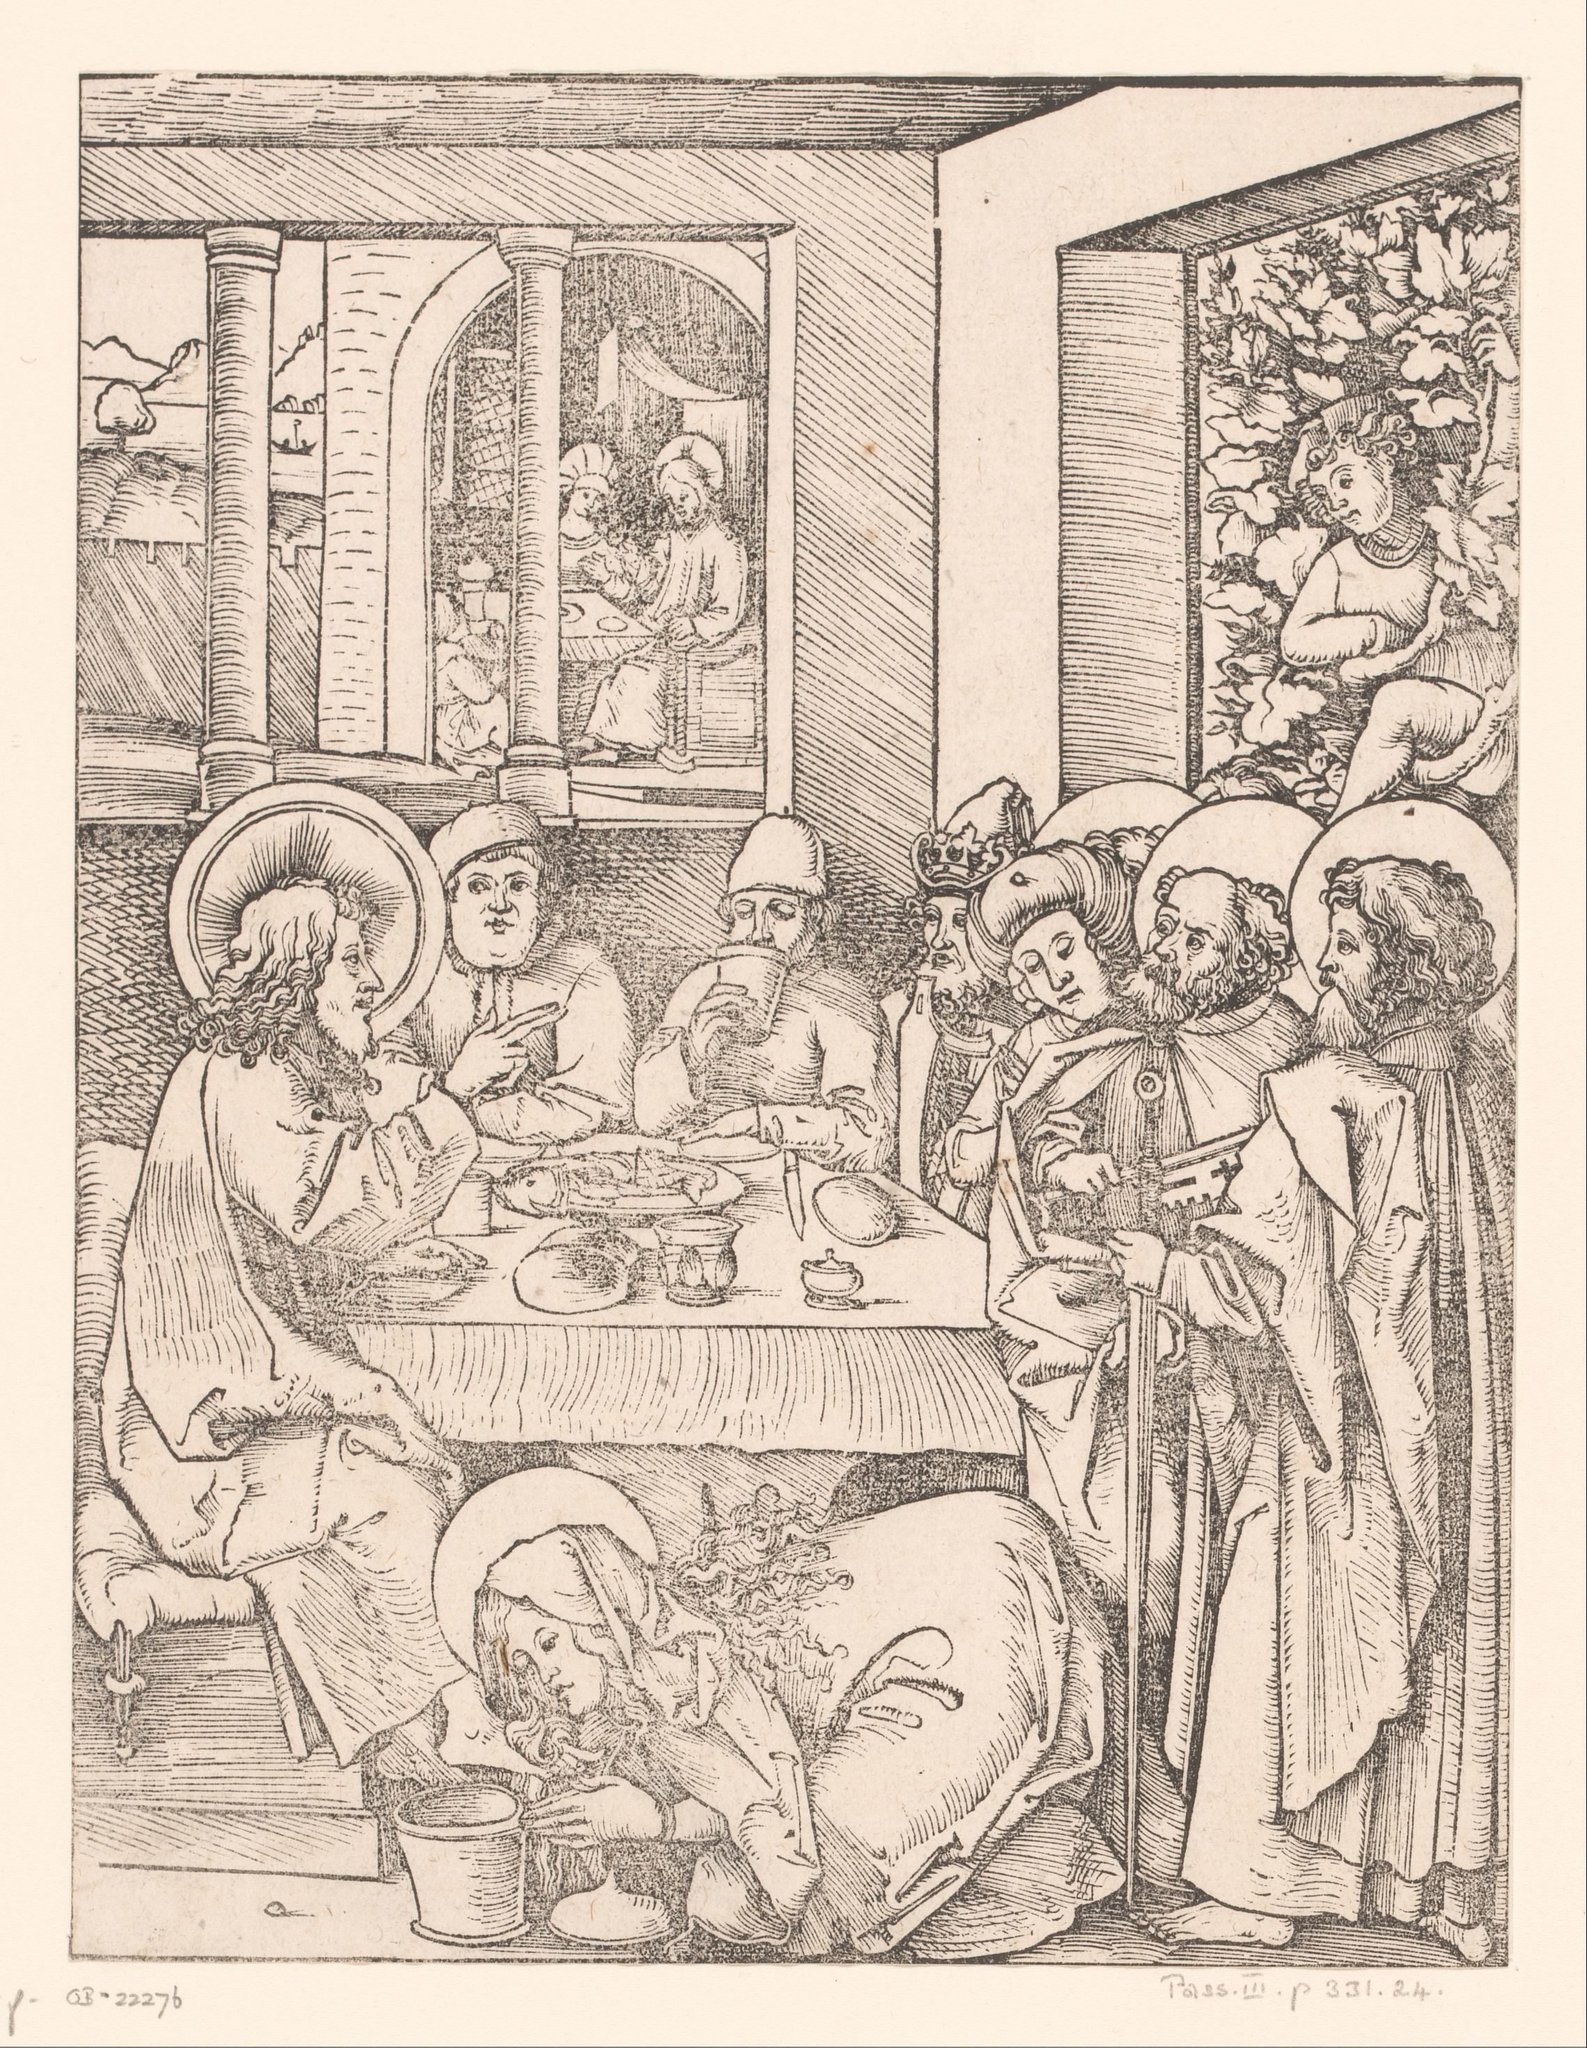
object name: print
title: Leven van Christus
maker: Anonymous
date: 1490-1526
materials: paper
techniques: woodcut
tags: meal at the house of simon the pharisee (luke 7:36-50)